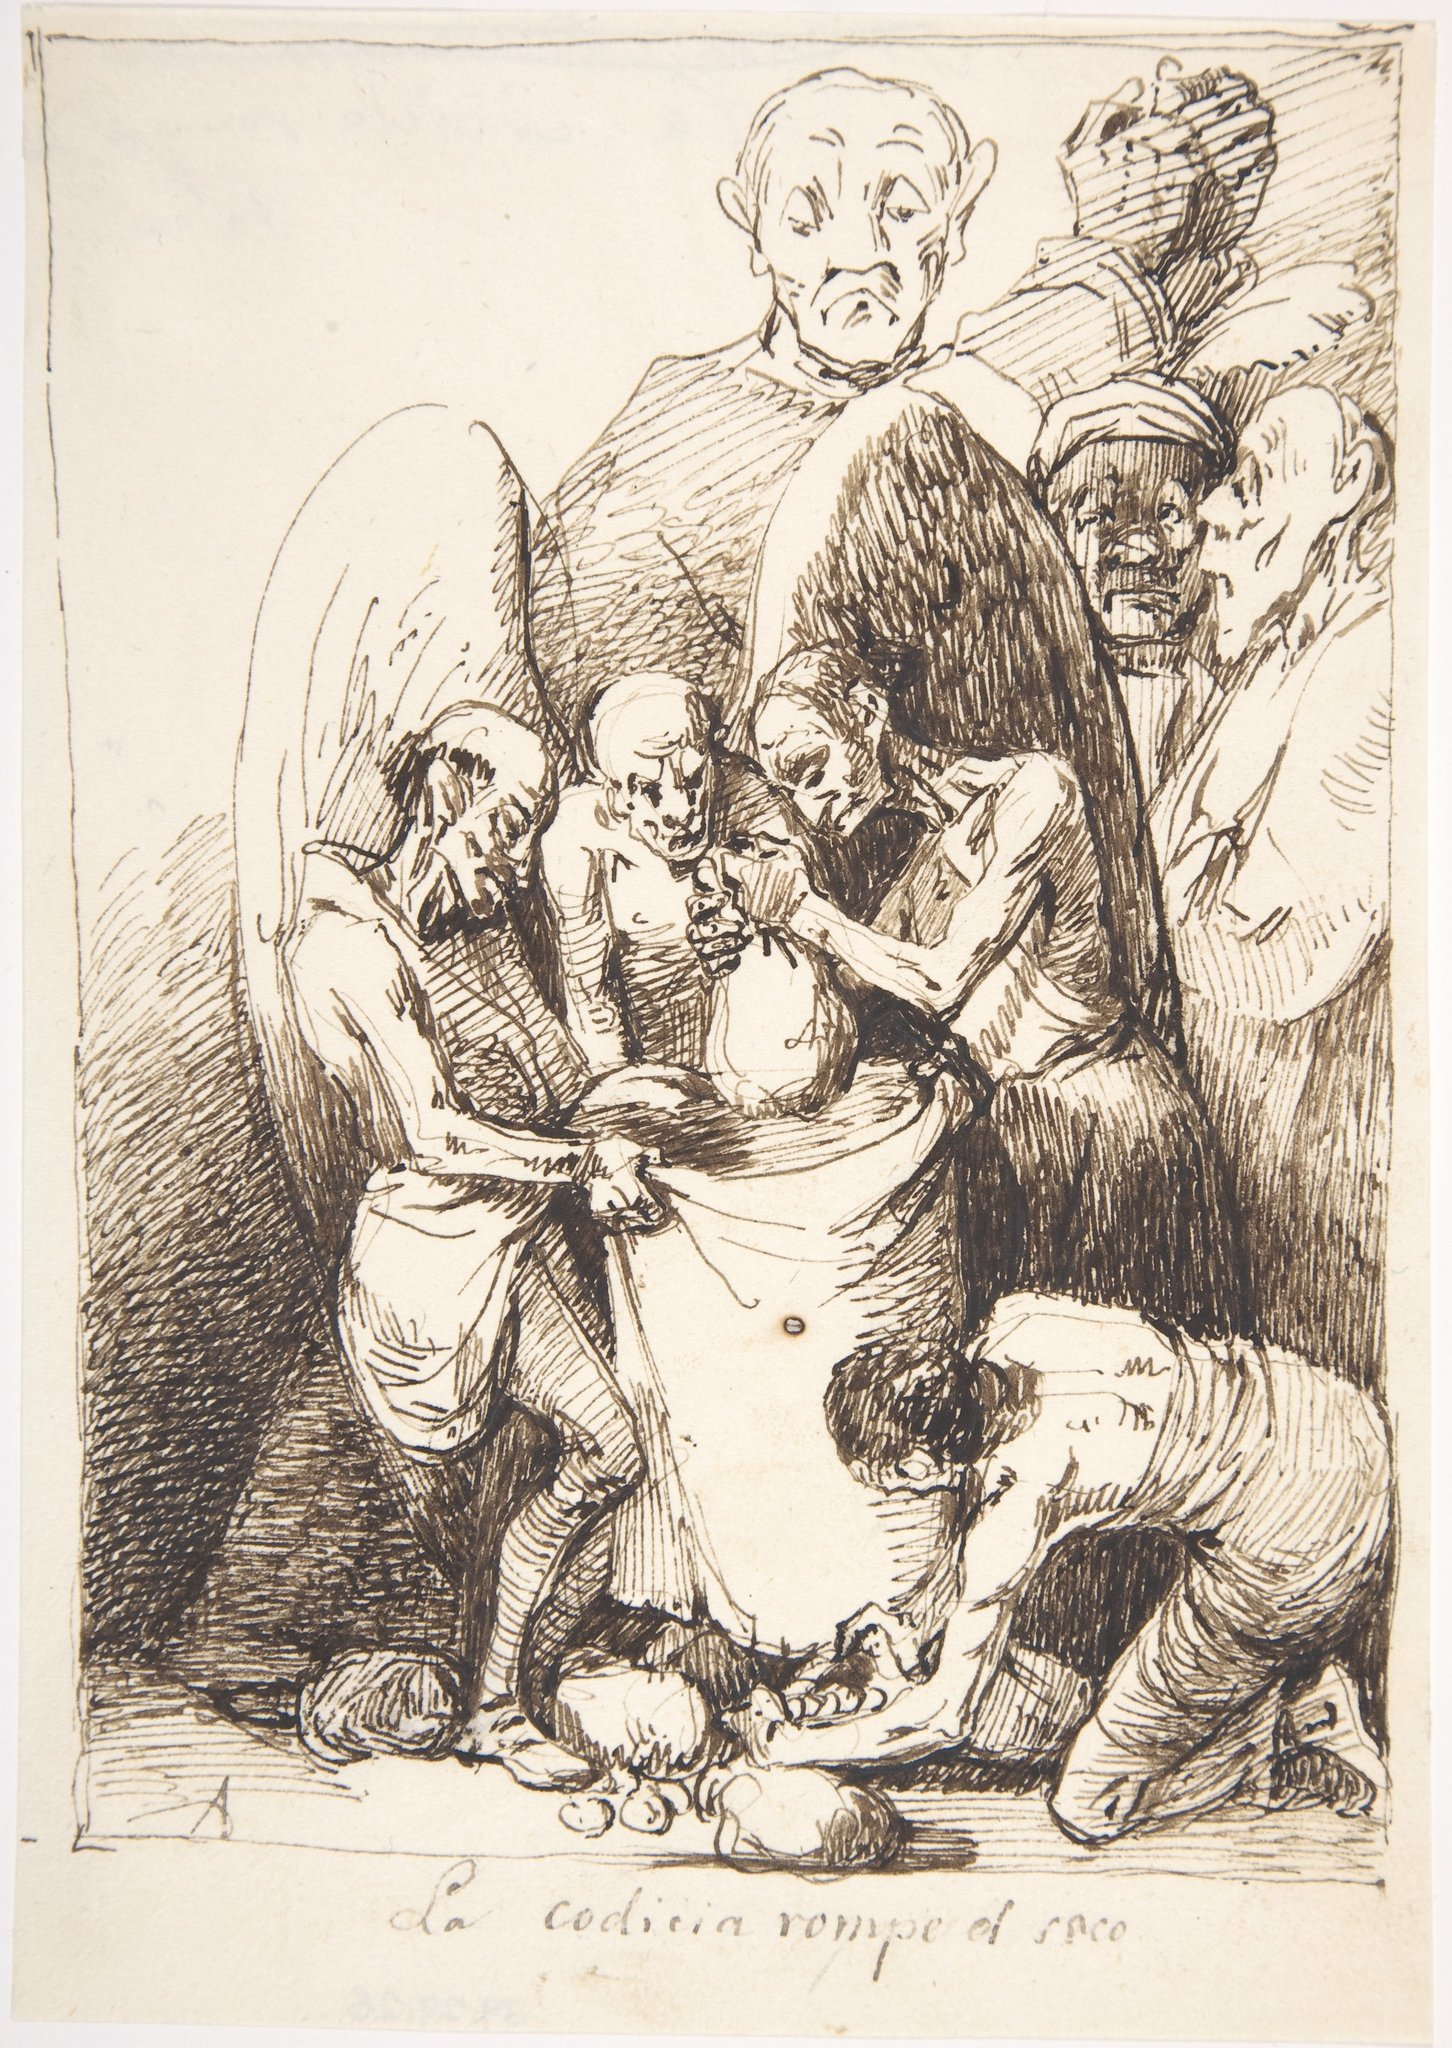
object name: drawing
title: Greed Breaks the Bag (La codicia rompe el saco)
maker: leonardo alenza y nieto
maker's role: artist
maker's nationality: spanish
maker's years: 1807-1845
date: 1807-1845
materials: ink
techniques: pen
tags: suffering,men